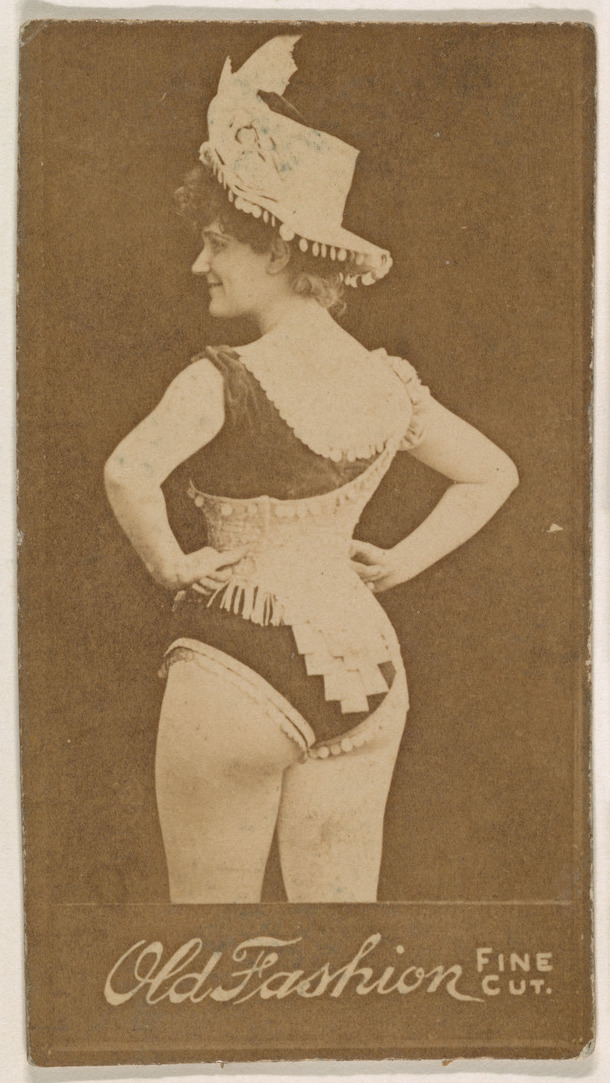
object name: photograph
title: Actress wearing fringed top hat, from the Actresses series (N664) promoting Old Fashion Fine Cut Tobacco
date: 1888-1890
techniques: albumen silver print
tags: portraits,women,actresses